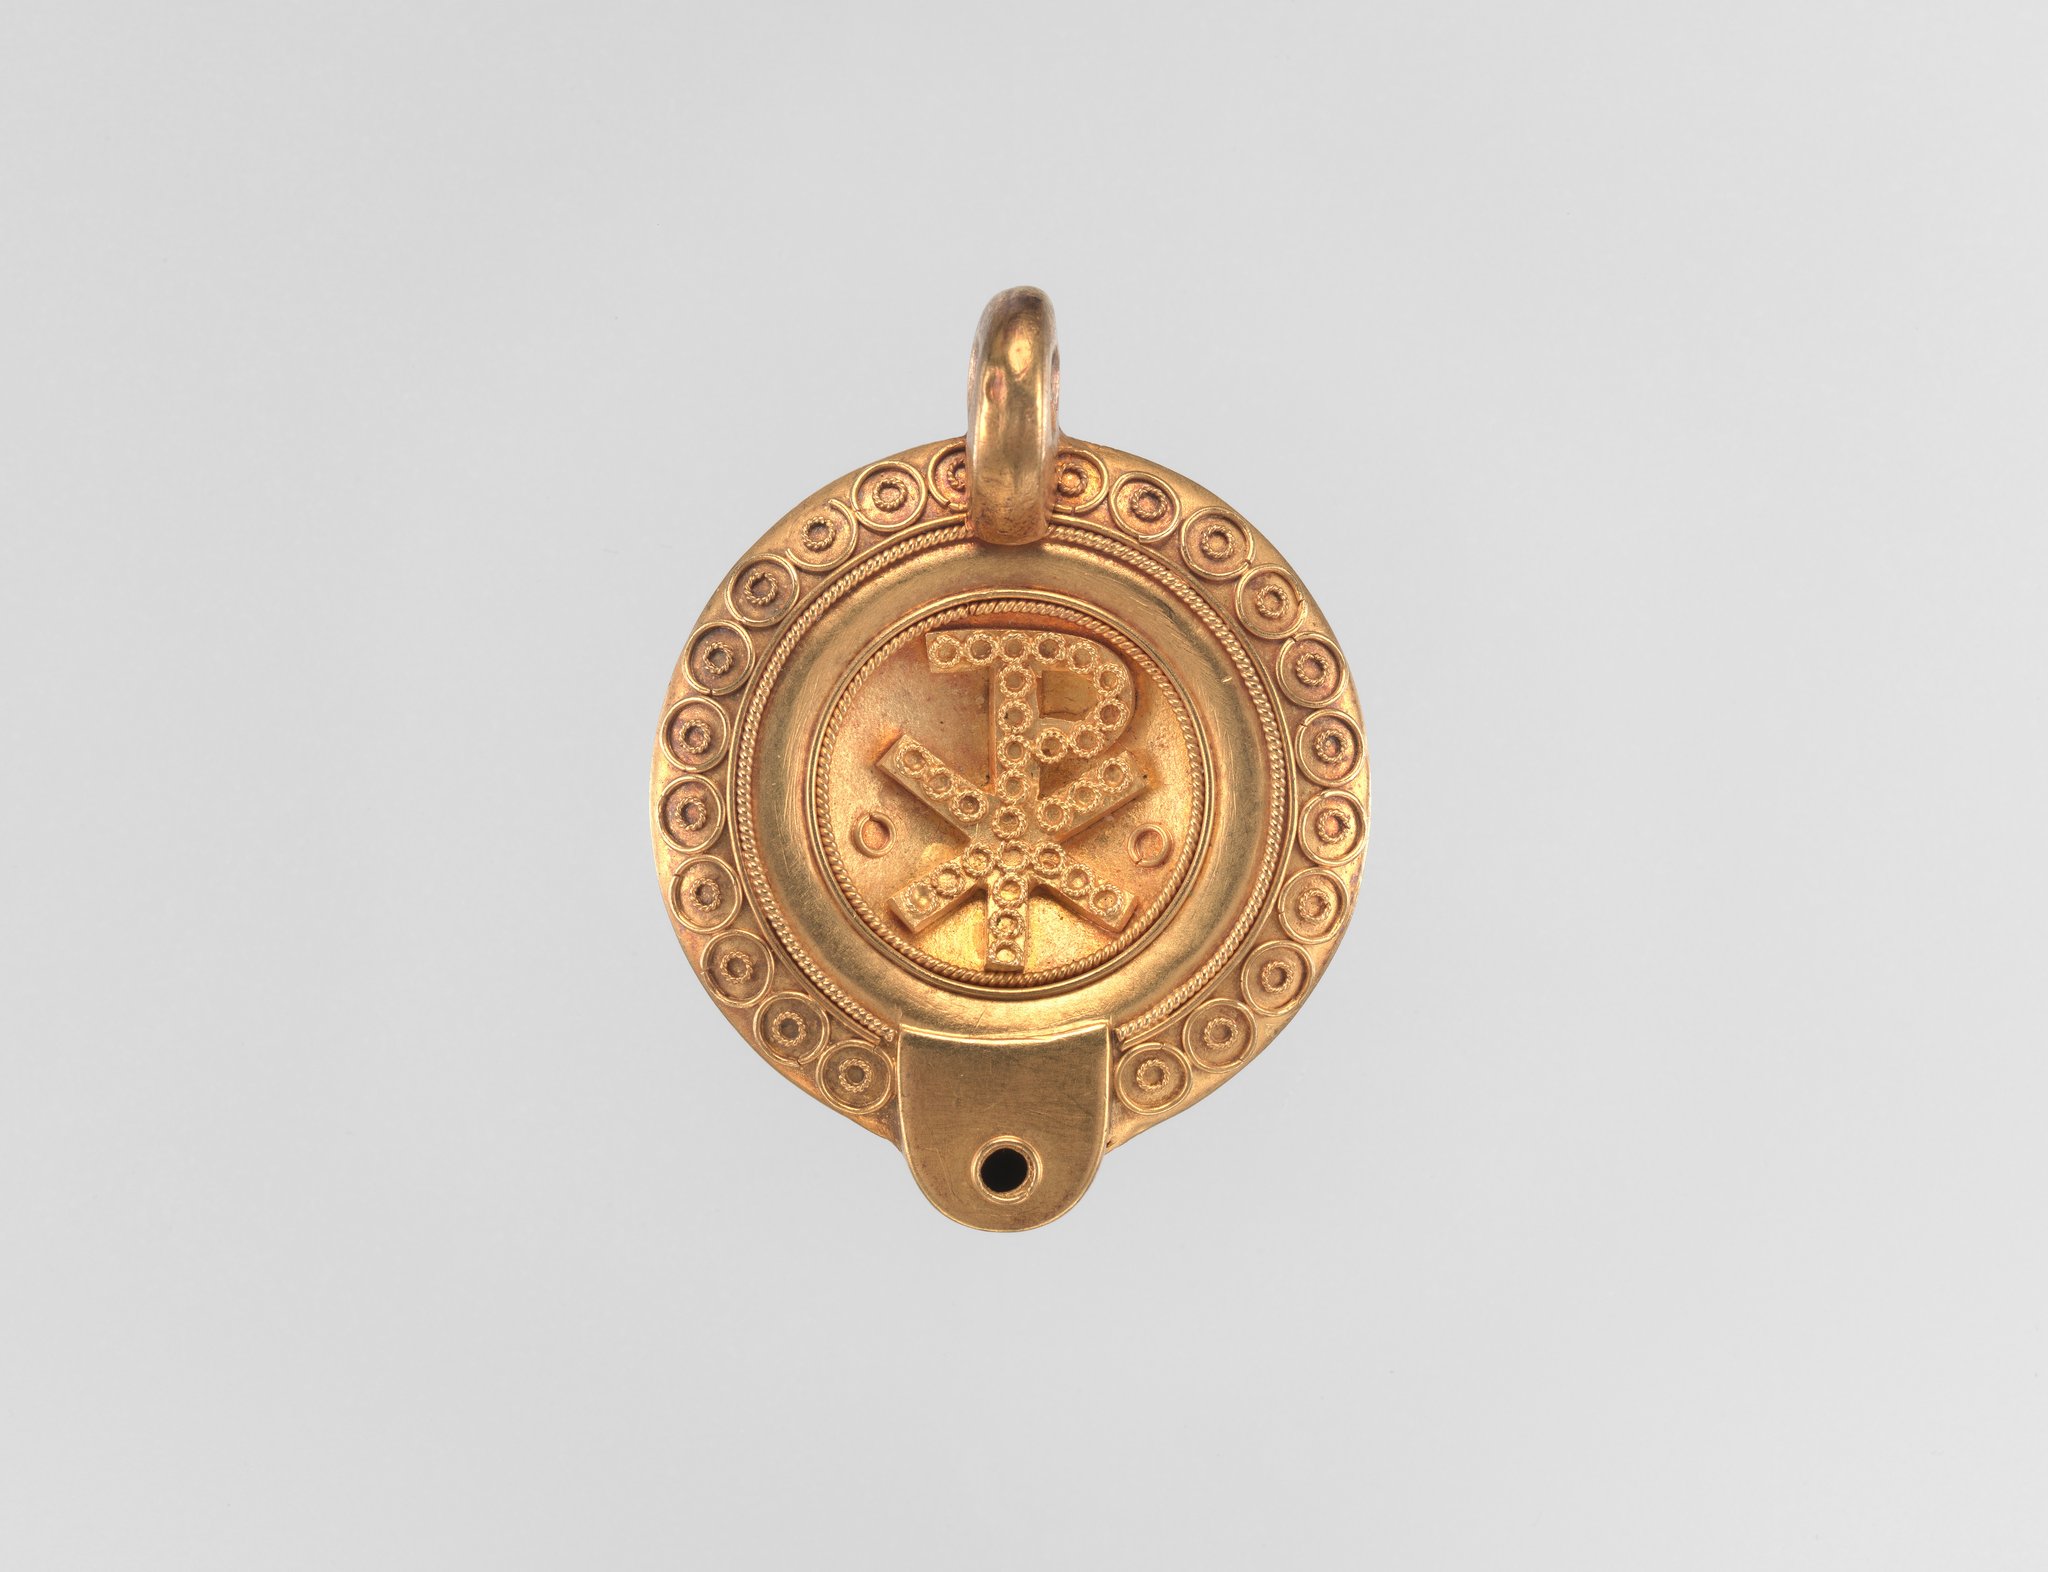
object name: pendant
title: Byzantine-revival pendant in the form of an oil lamp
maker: castellani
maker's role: maker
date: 1870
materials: glass, gold